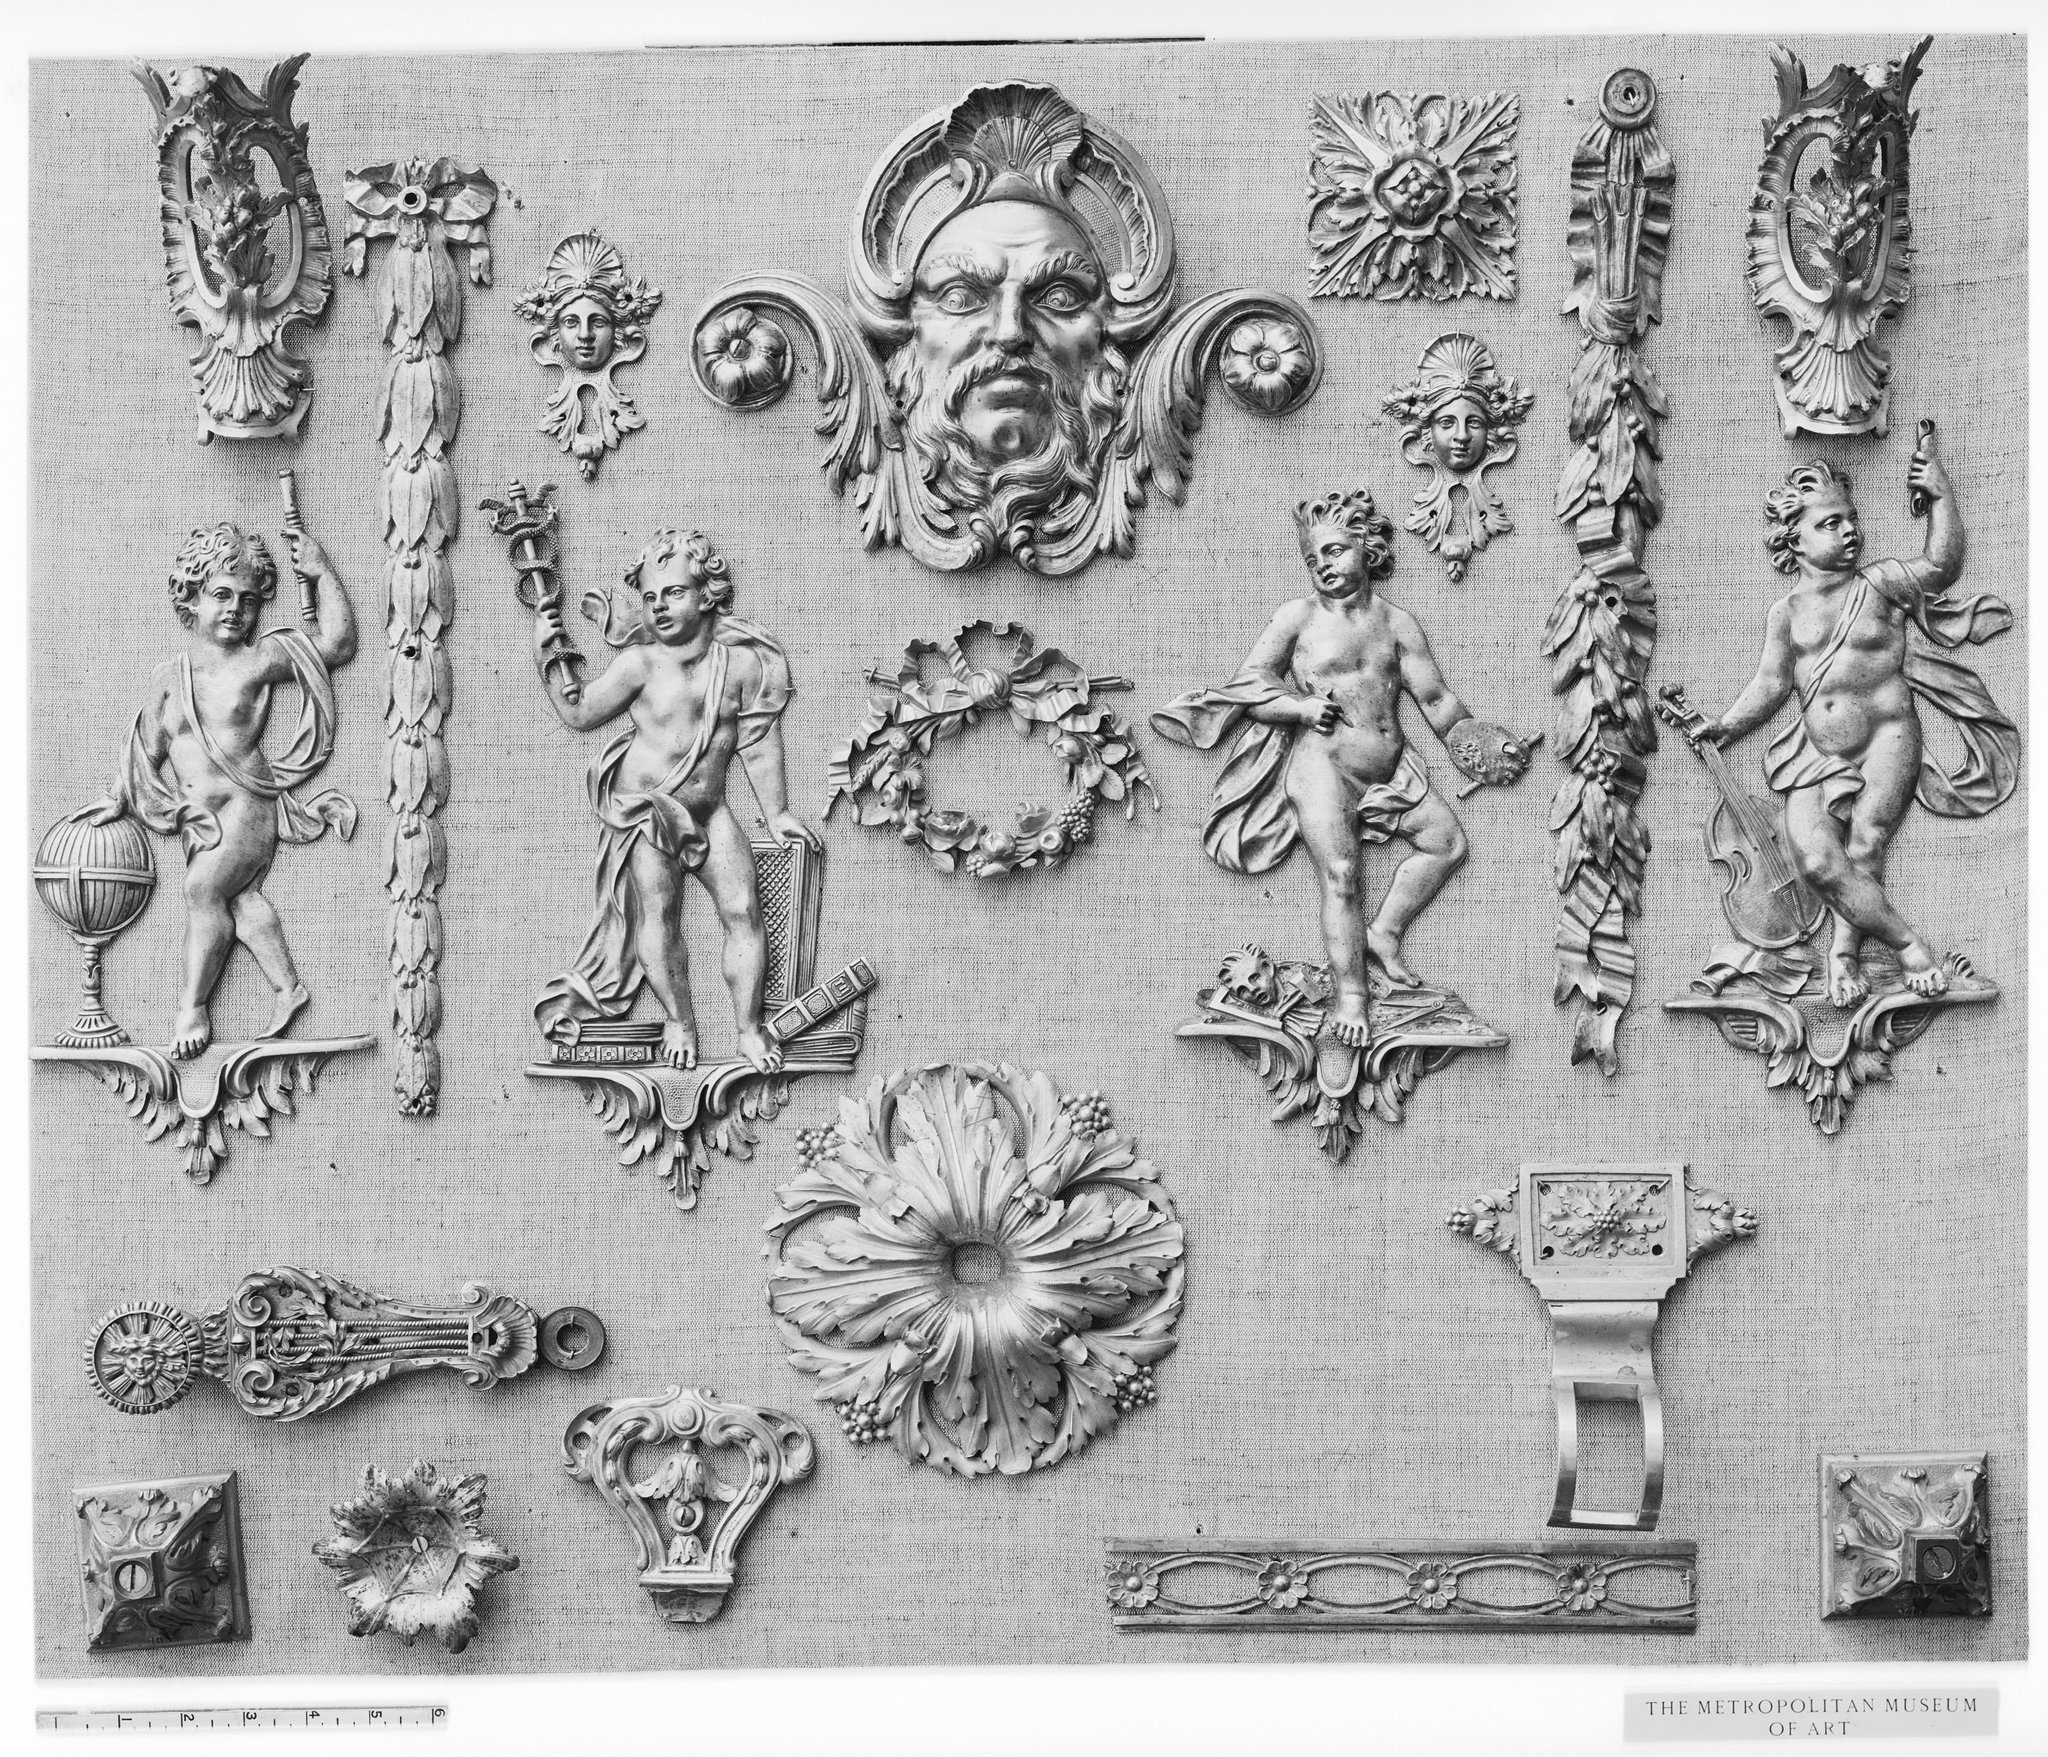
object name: bobeche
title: Bobêche (?)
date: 1701-1800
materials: gilt bronze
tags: faces,male nudes